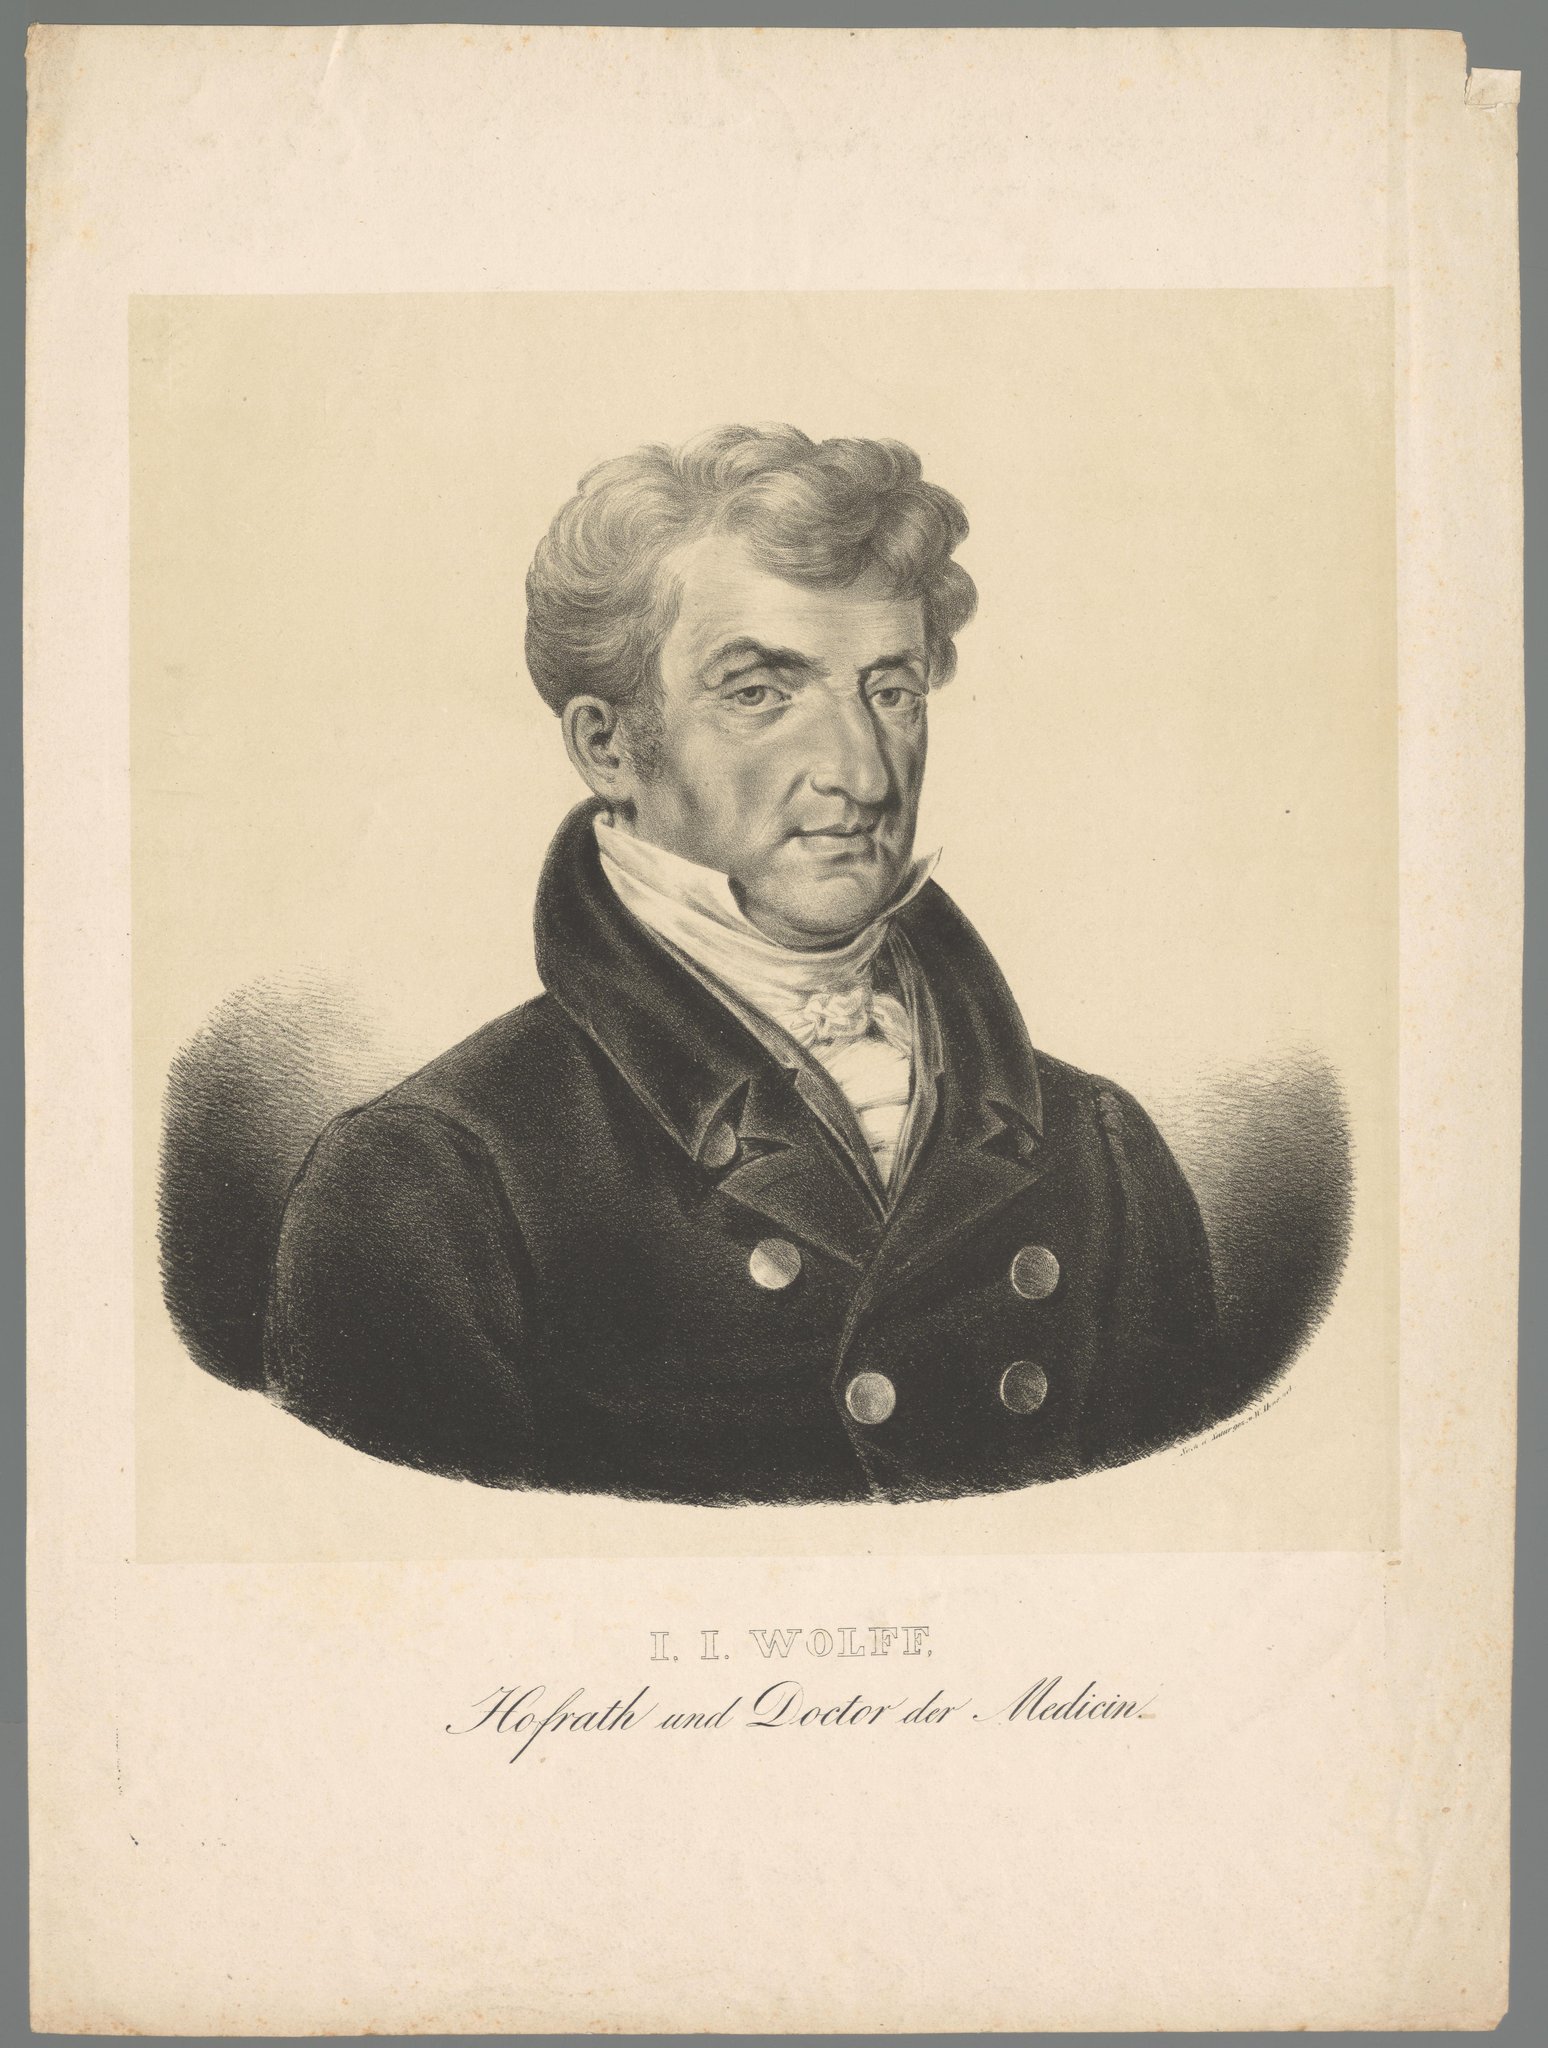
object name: print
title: Portret van Wolff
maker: wilhelm henschel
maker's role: print maker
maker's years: 1781-1865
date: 1791-1865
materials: paper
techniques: lithograph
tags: physician, doctor, historical persons not known by name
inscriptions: collector's mark: Lugt 2228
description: Portret van een verder onbekende man met de naam I.I. (of J.J.) Wolff. Volgens het onderschrift was hij arts.